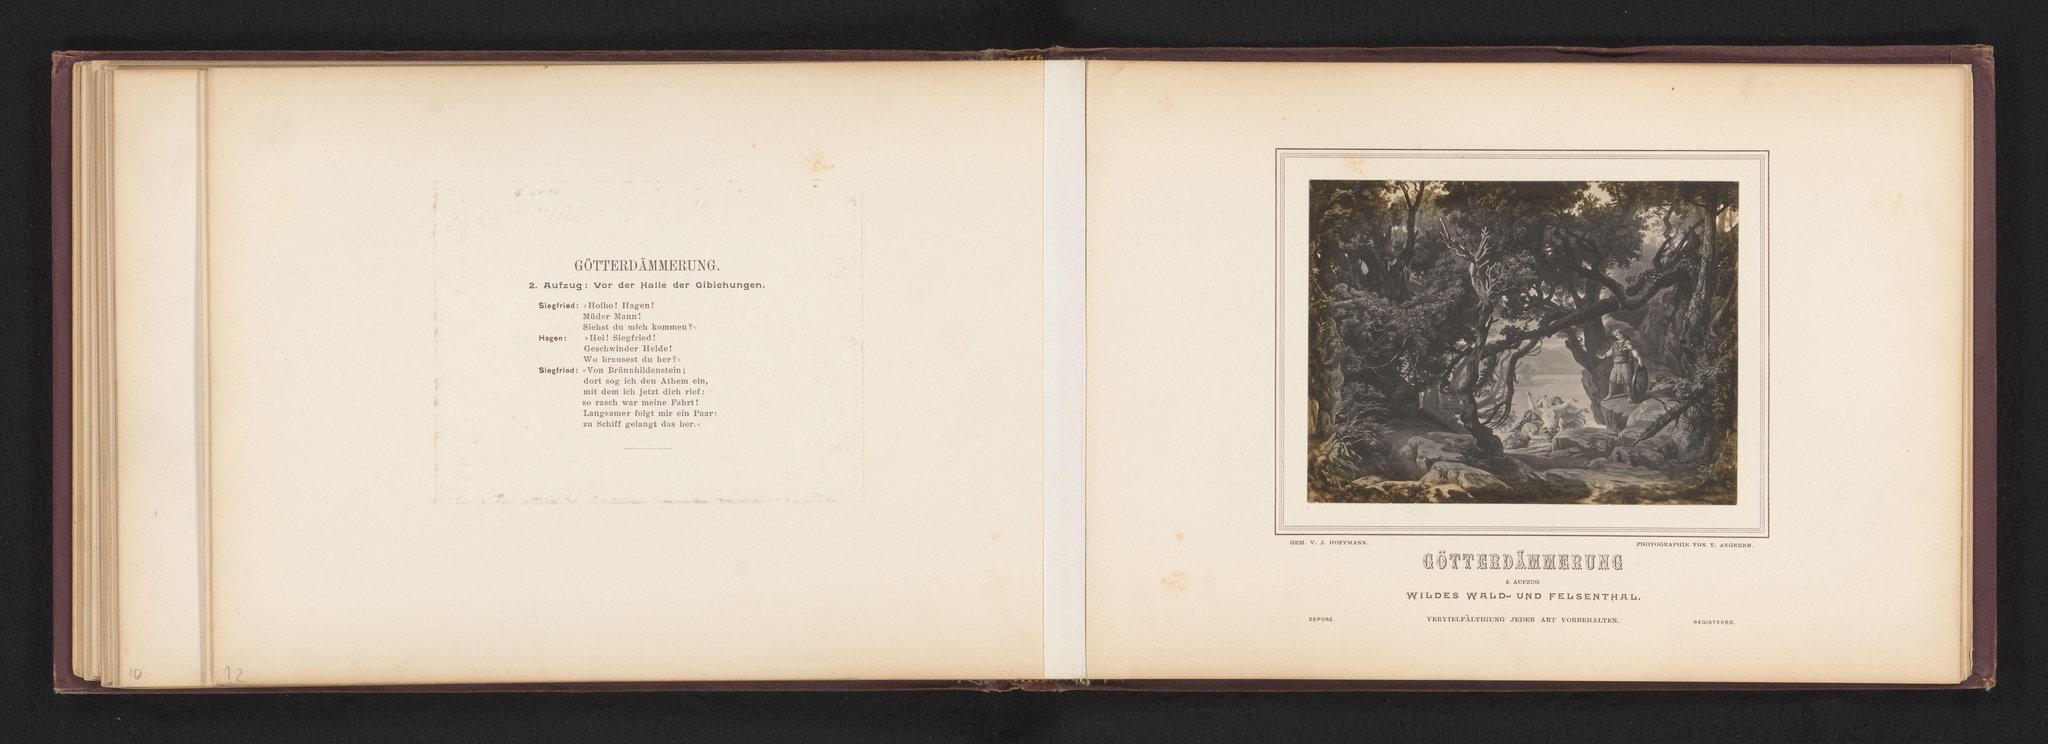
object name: page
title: Wildes wald- und felsenthal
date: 1866-1876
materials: photographic support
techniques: albumen print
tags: 'nibelungenlied', siegfried, forest, wood